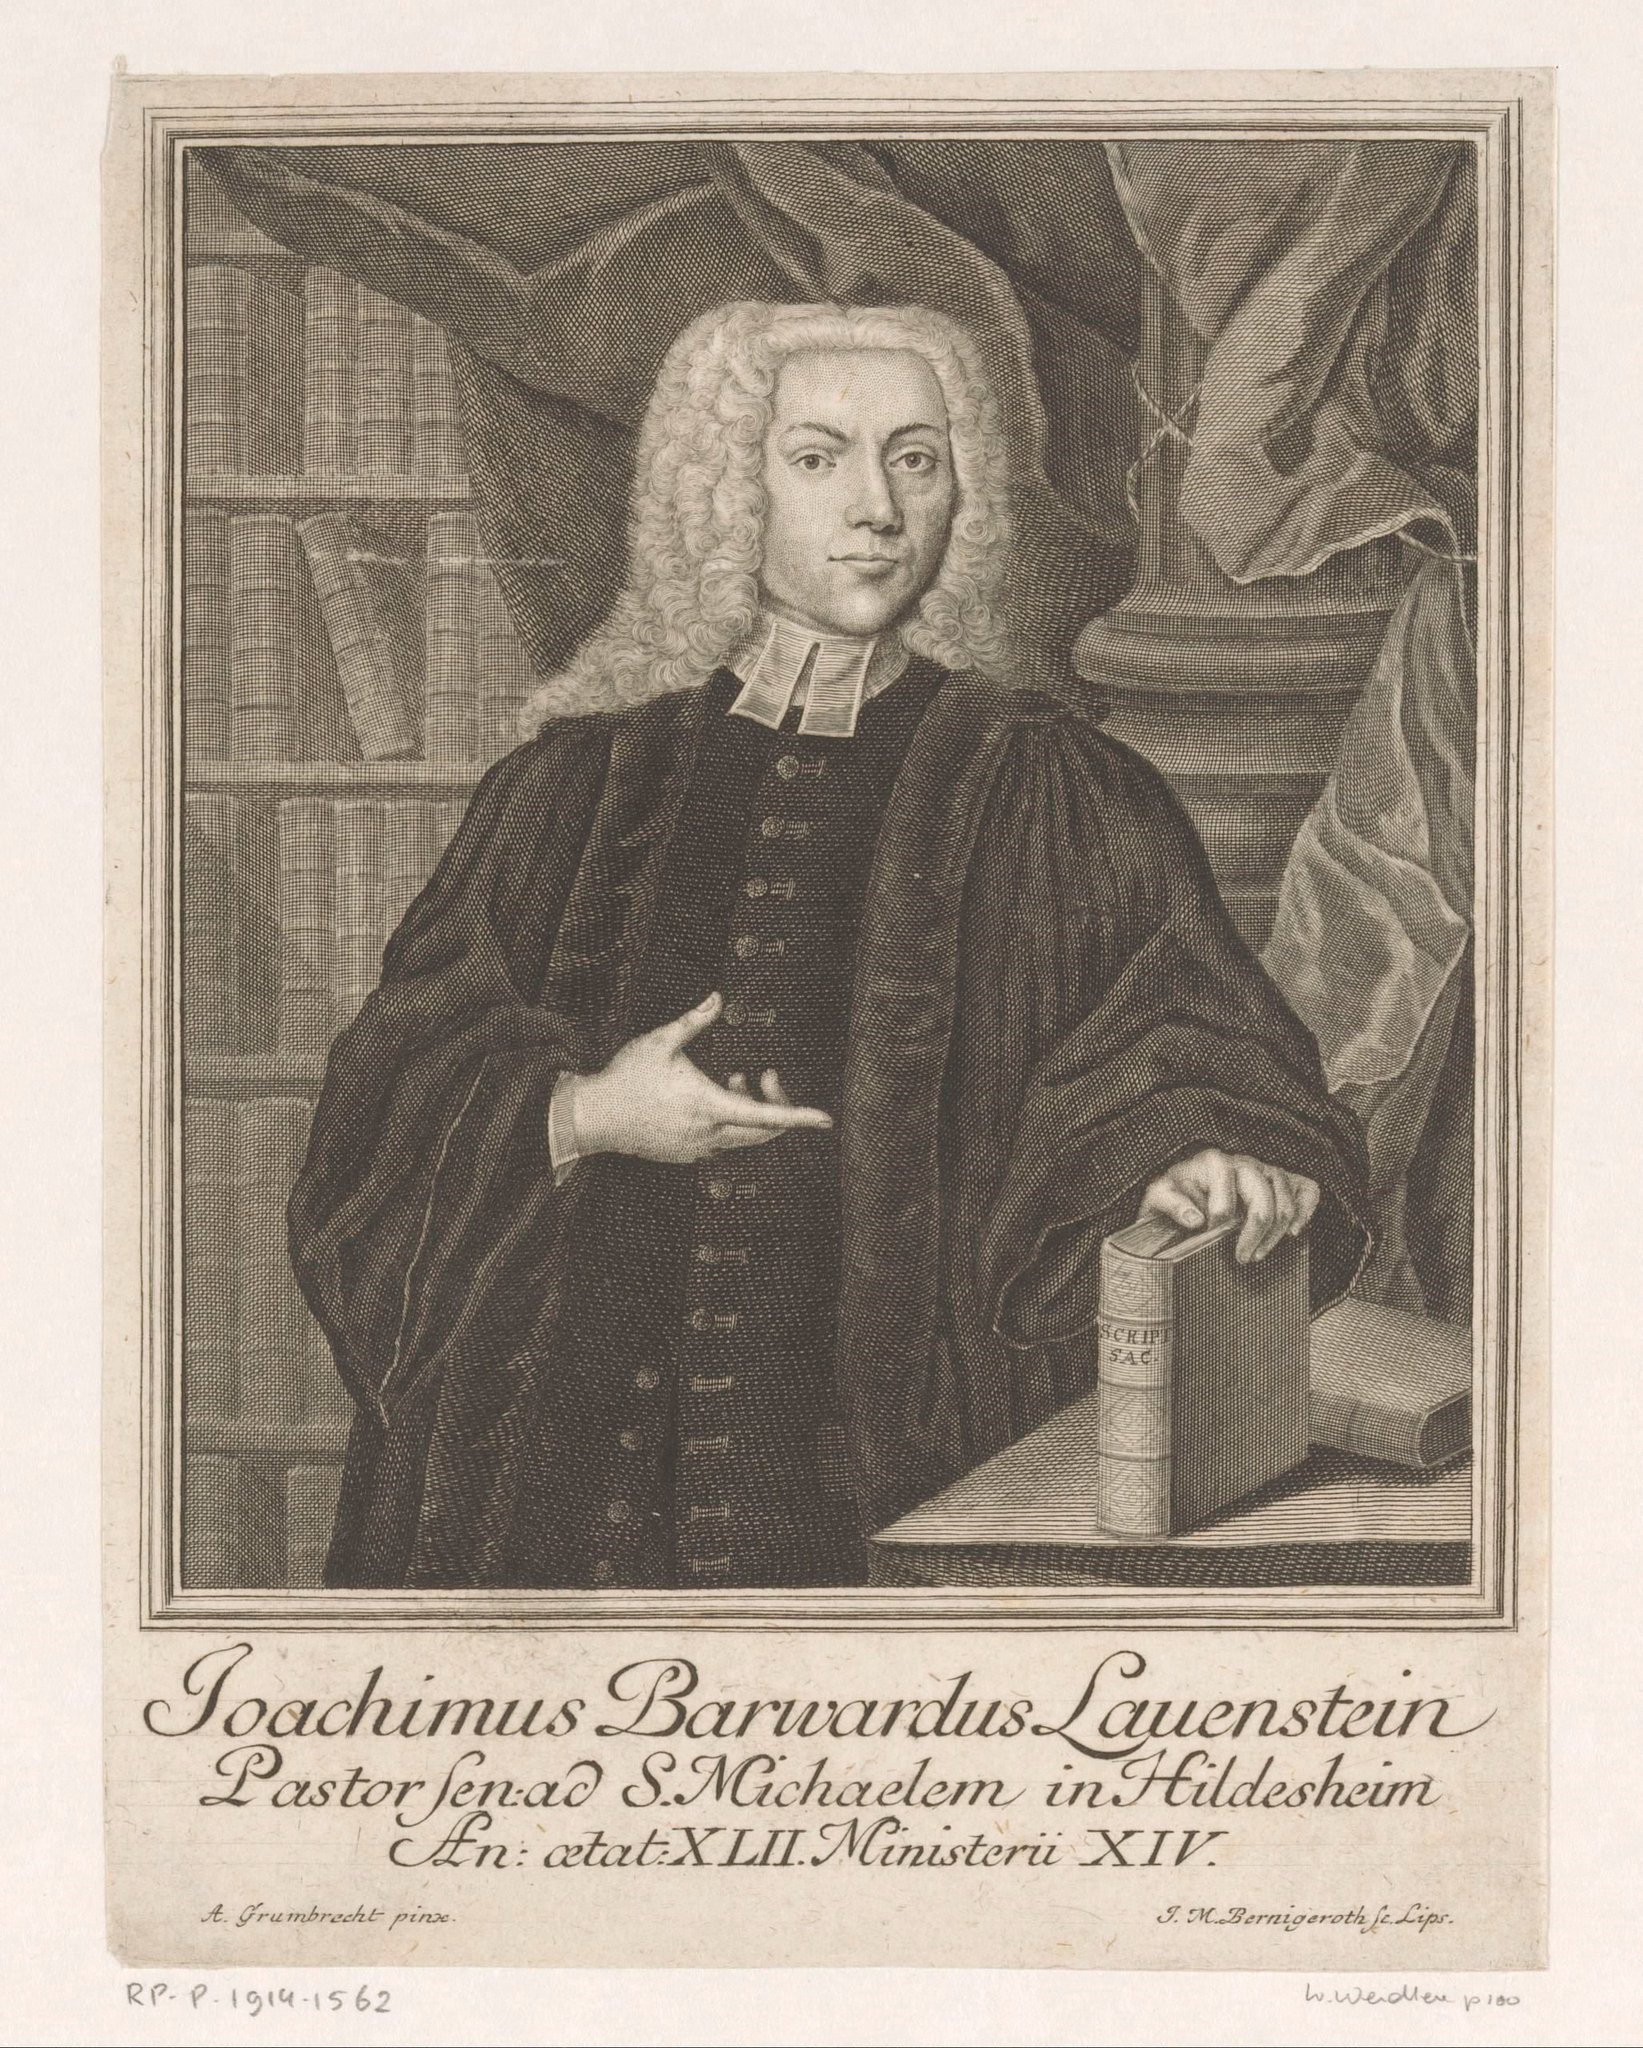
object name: print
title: Portret van Joachim Barward Lauenstein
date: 1740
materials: paper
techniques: engraving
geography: leipzig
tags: bookshelves, historical persons, book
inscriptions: collector's mark: Lugt 2228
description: Prent ook gebruikt in: Lauenstein, Joachim Barward. Historia diplomatica Episcopatus Hildesiensis. Das ist: Diplomatische Historie des Bißthums Hildesheim (...). Hildesheim: weduwe Ludolph Schröder, 1740.